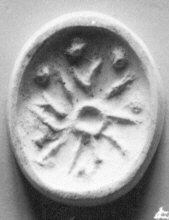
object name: stamp seal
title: Stamp seal (bifacial scaraboid) with animal and divine symbol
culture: assyrian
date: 734-601 BCE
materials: limestone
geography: mesopotamia or syria